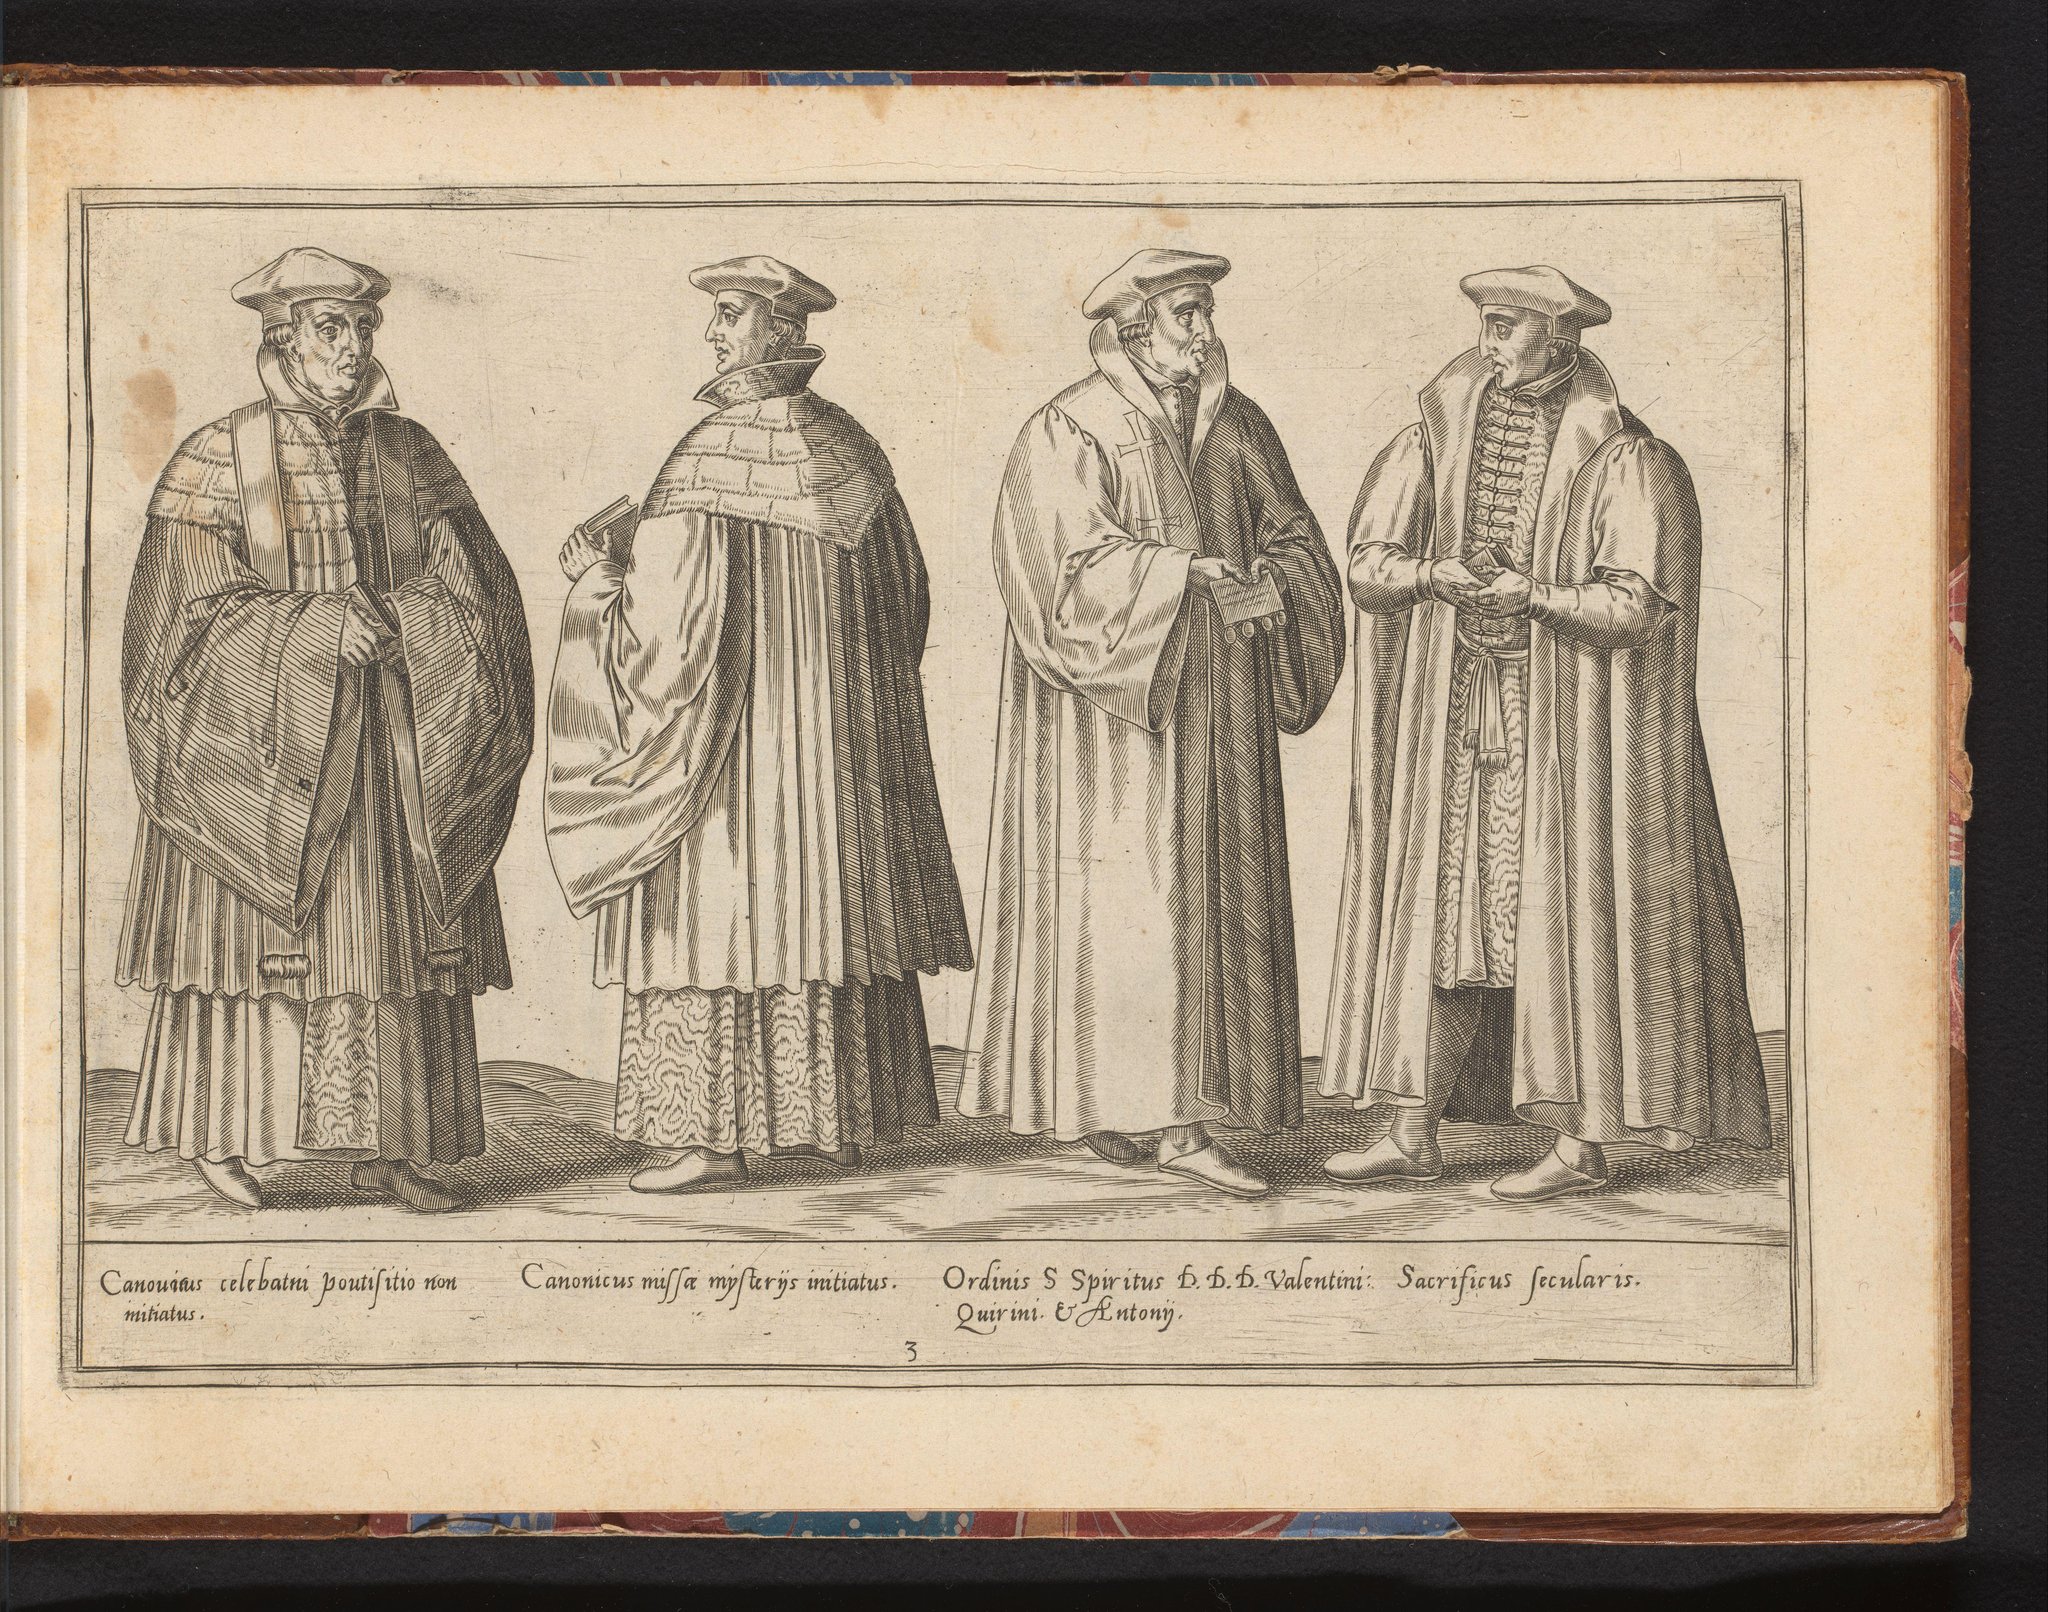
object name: album leaf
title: Vier kanunniken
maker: abraham de bruyn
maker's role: print maker, publisher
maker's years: 1540-1587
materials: paper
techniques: engraving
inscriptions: number: ‘3’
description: Prent uit het boek 'Omnium pene Europae, Asiae, Aphricae atque Americae gentium habitus...', 1581. De prent maakt deel uit van een album.